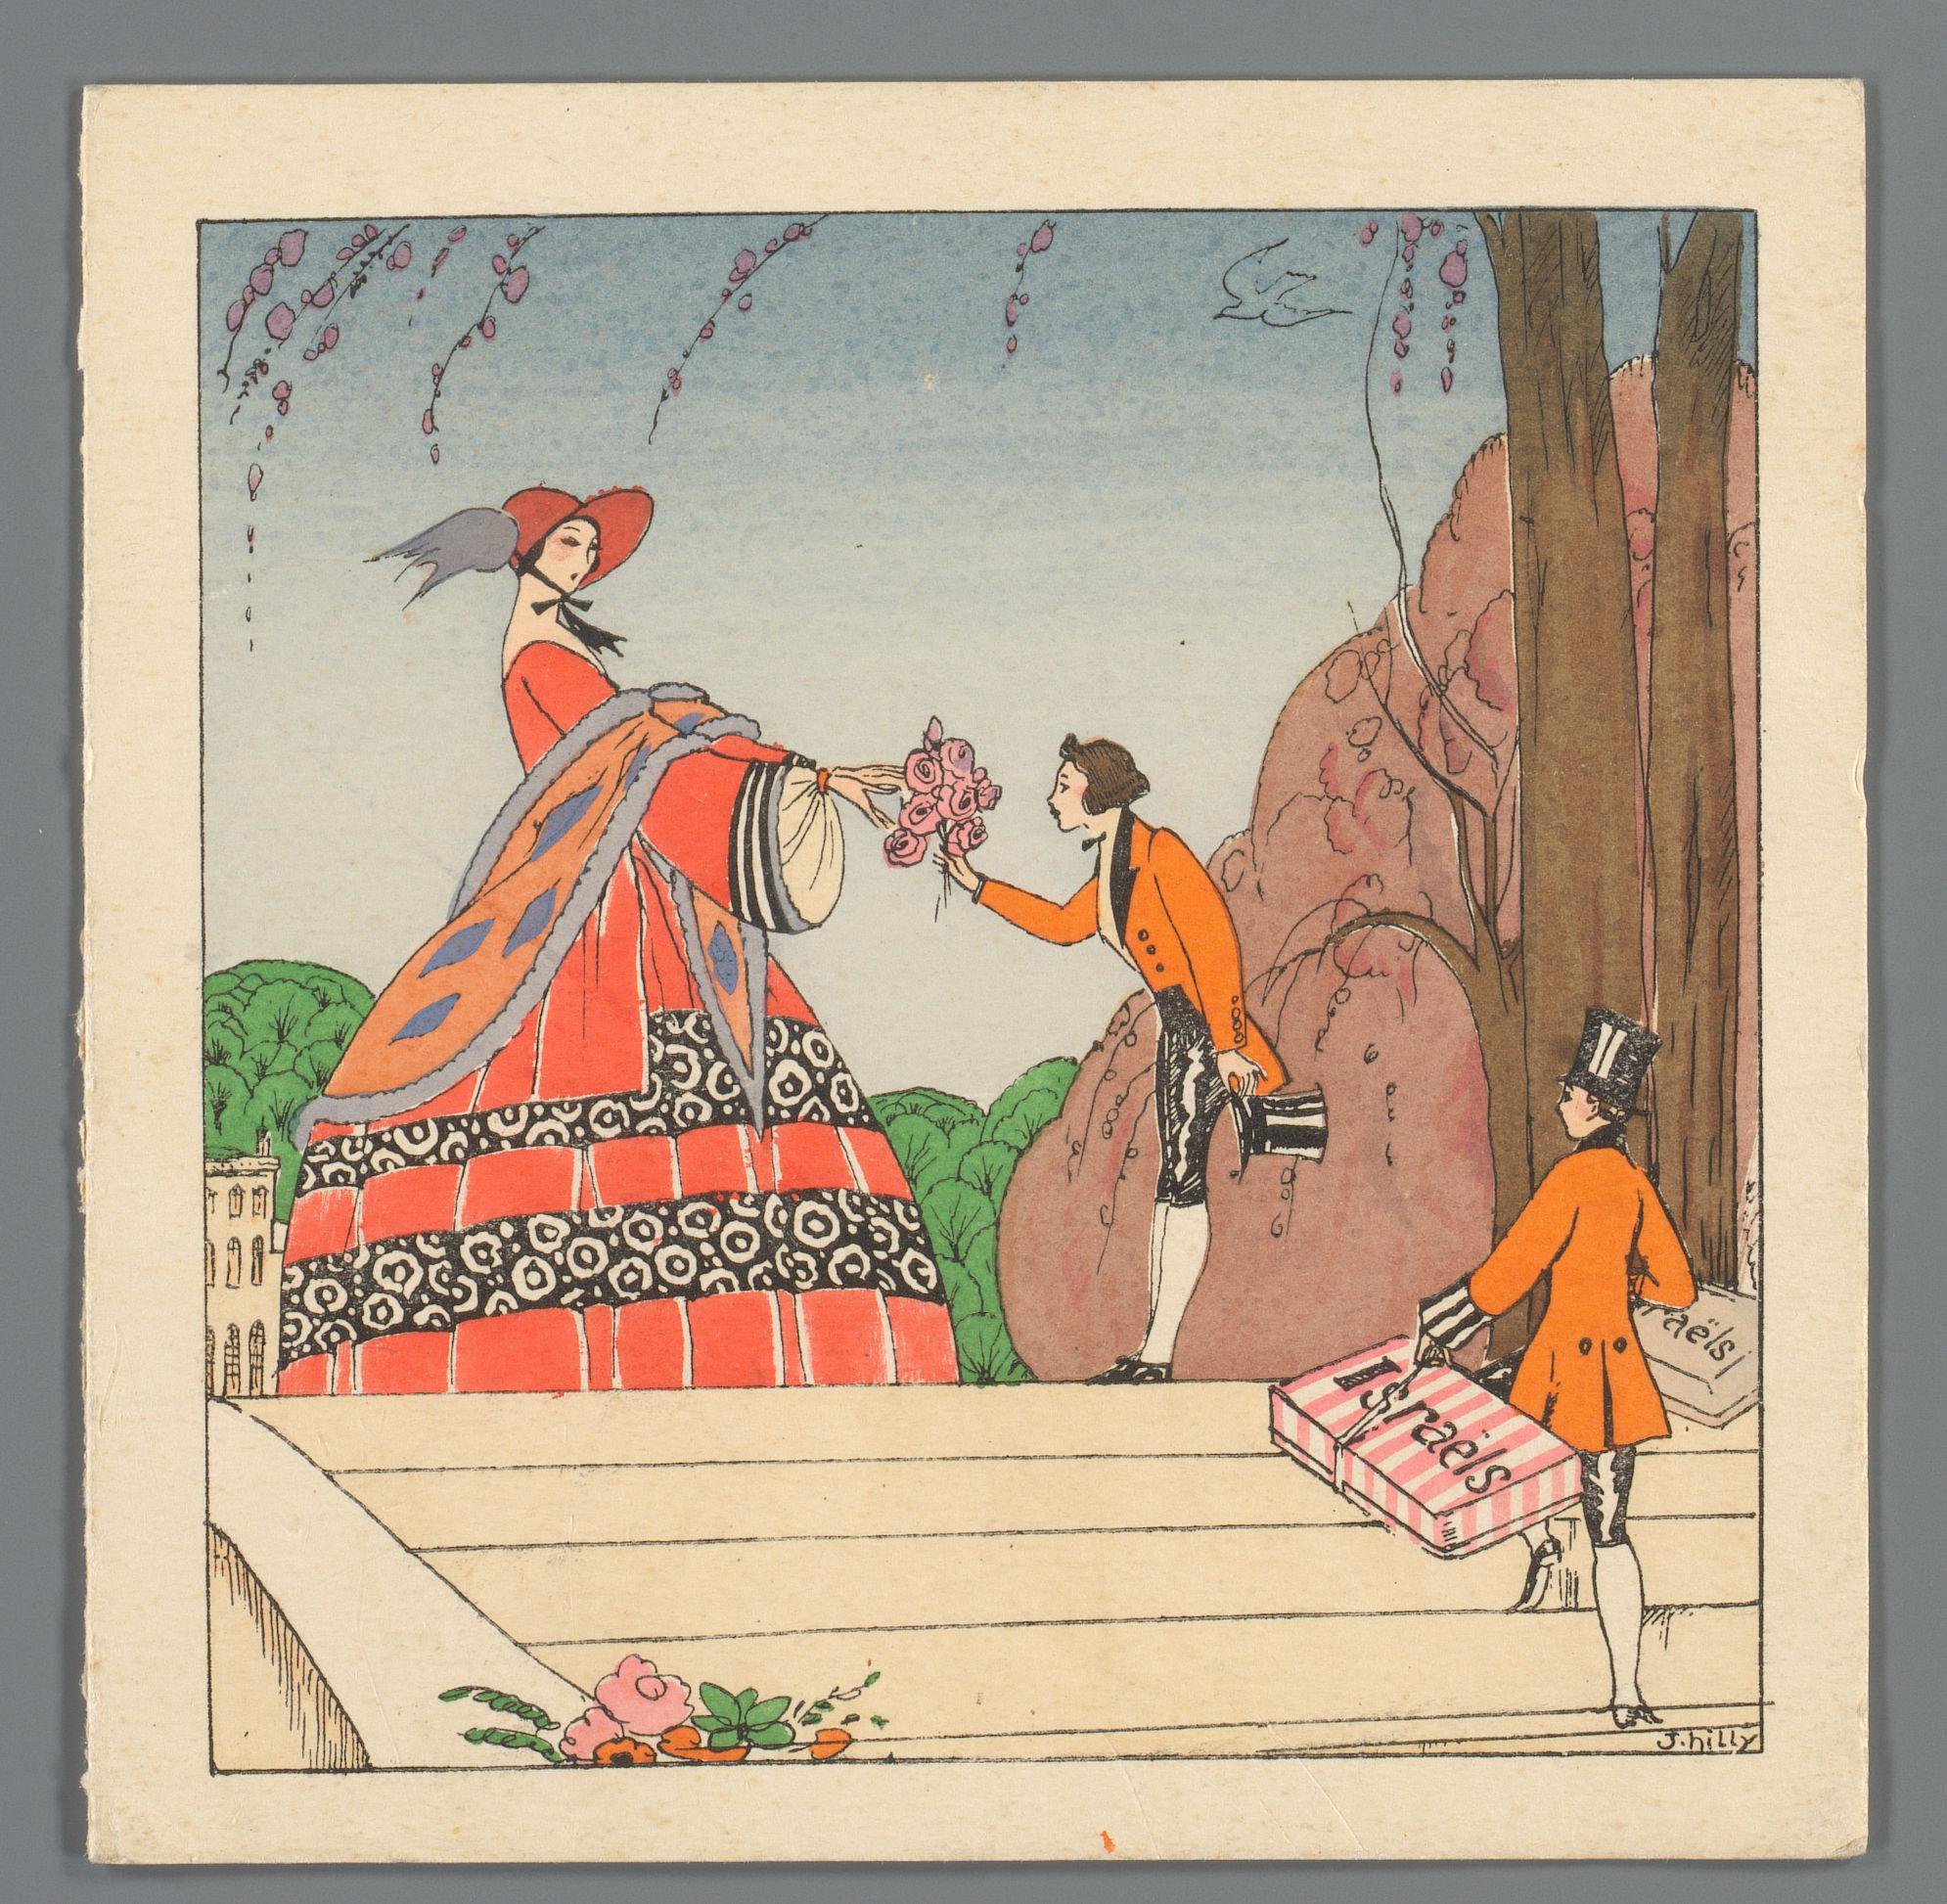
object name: photomechanical print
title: Uitnodiging van de Amsterdamse modezaak Israëls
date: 1903-1925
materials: paper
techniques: hand coloring, printing block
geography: paris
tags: delivering; receiving (~ postal matter), fashionable woman, 'belle'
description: Op de voorzijde komen twee bodes bloemen en dozen met nieuwe kleding (met op de dozen de naam Israëls) brengen aan een rijk uitgedoste vrouw. Binnenin de tekst: 'Wij hebben de eer U de ontvangst te berichten der nieuwe collectie Parijsche Modellen en noodigen U beleefd tot een bezoek uit', gevolgd door het adres (Van Baerlestraat 18 Amsterdam).